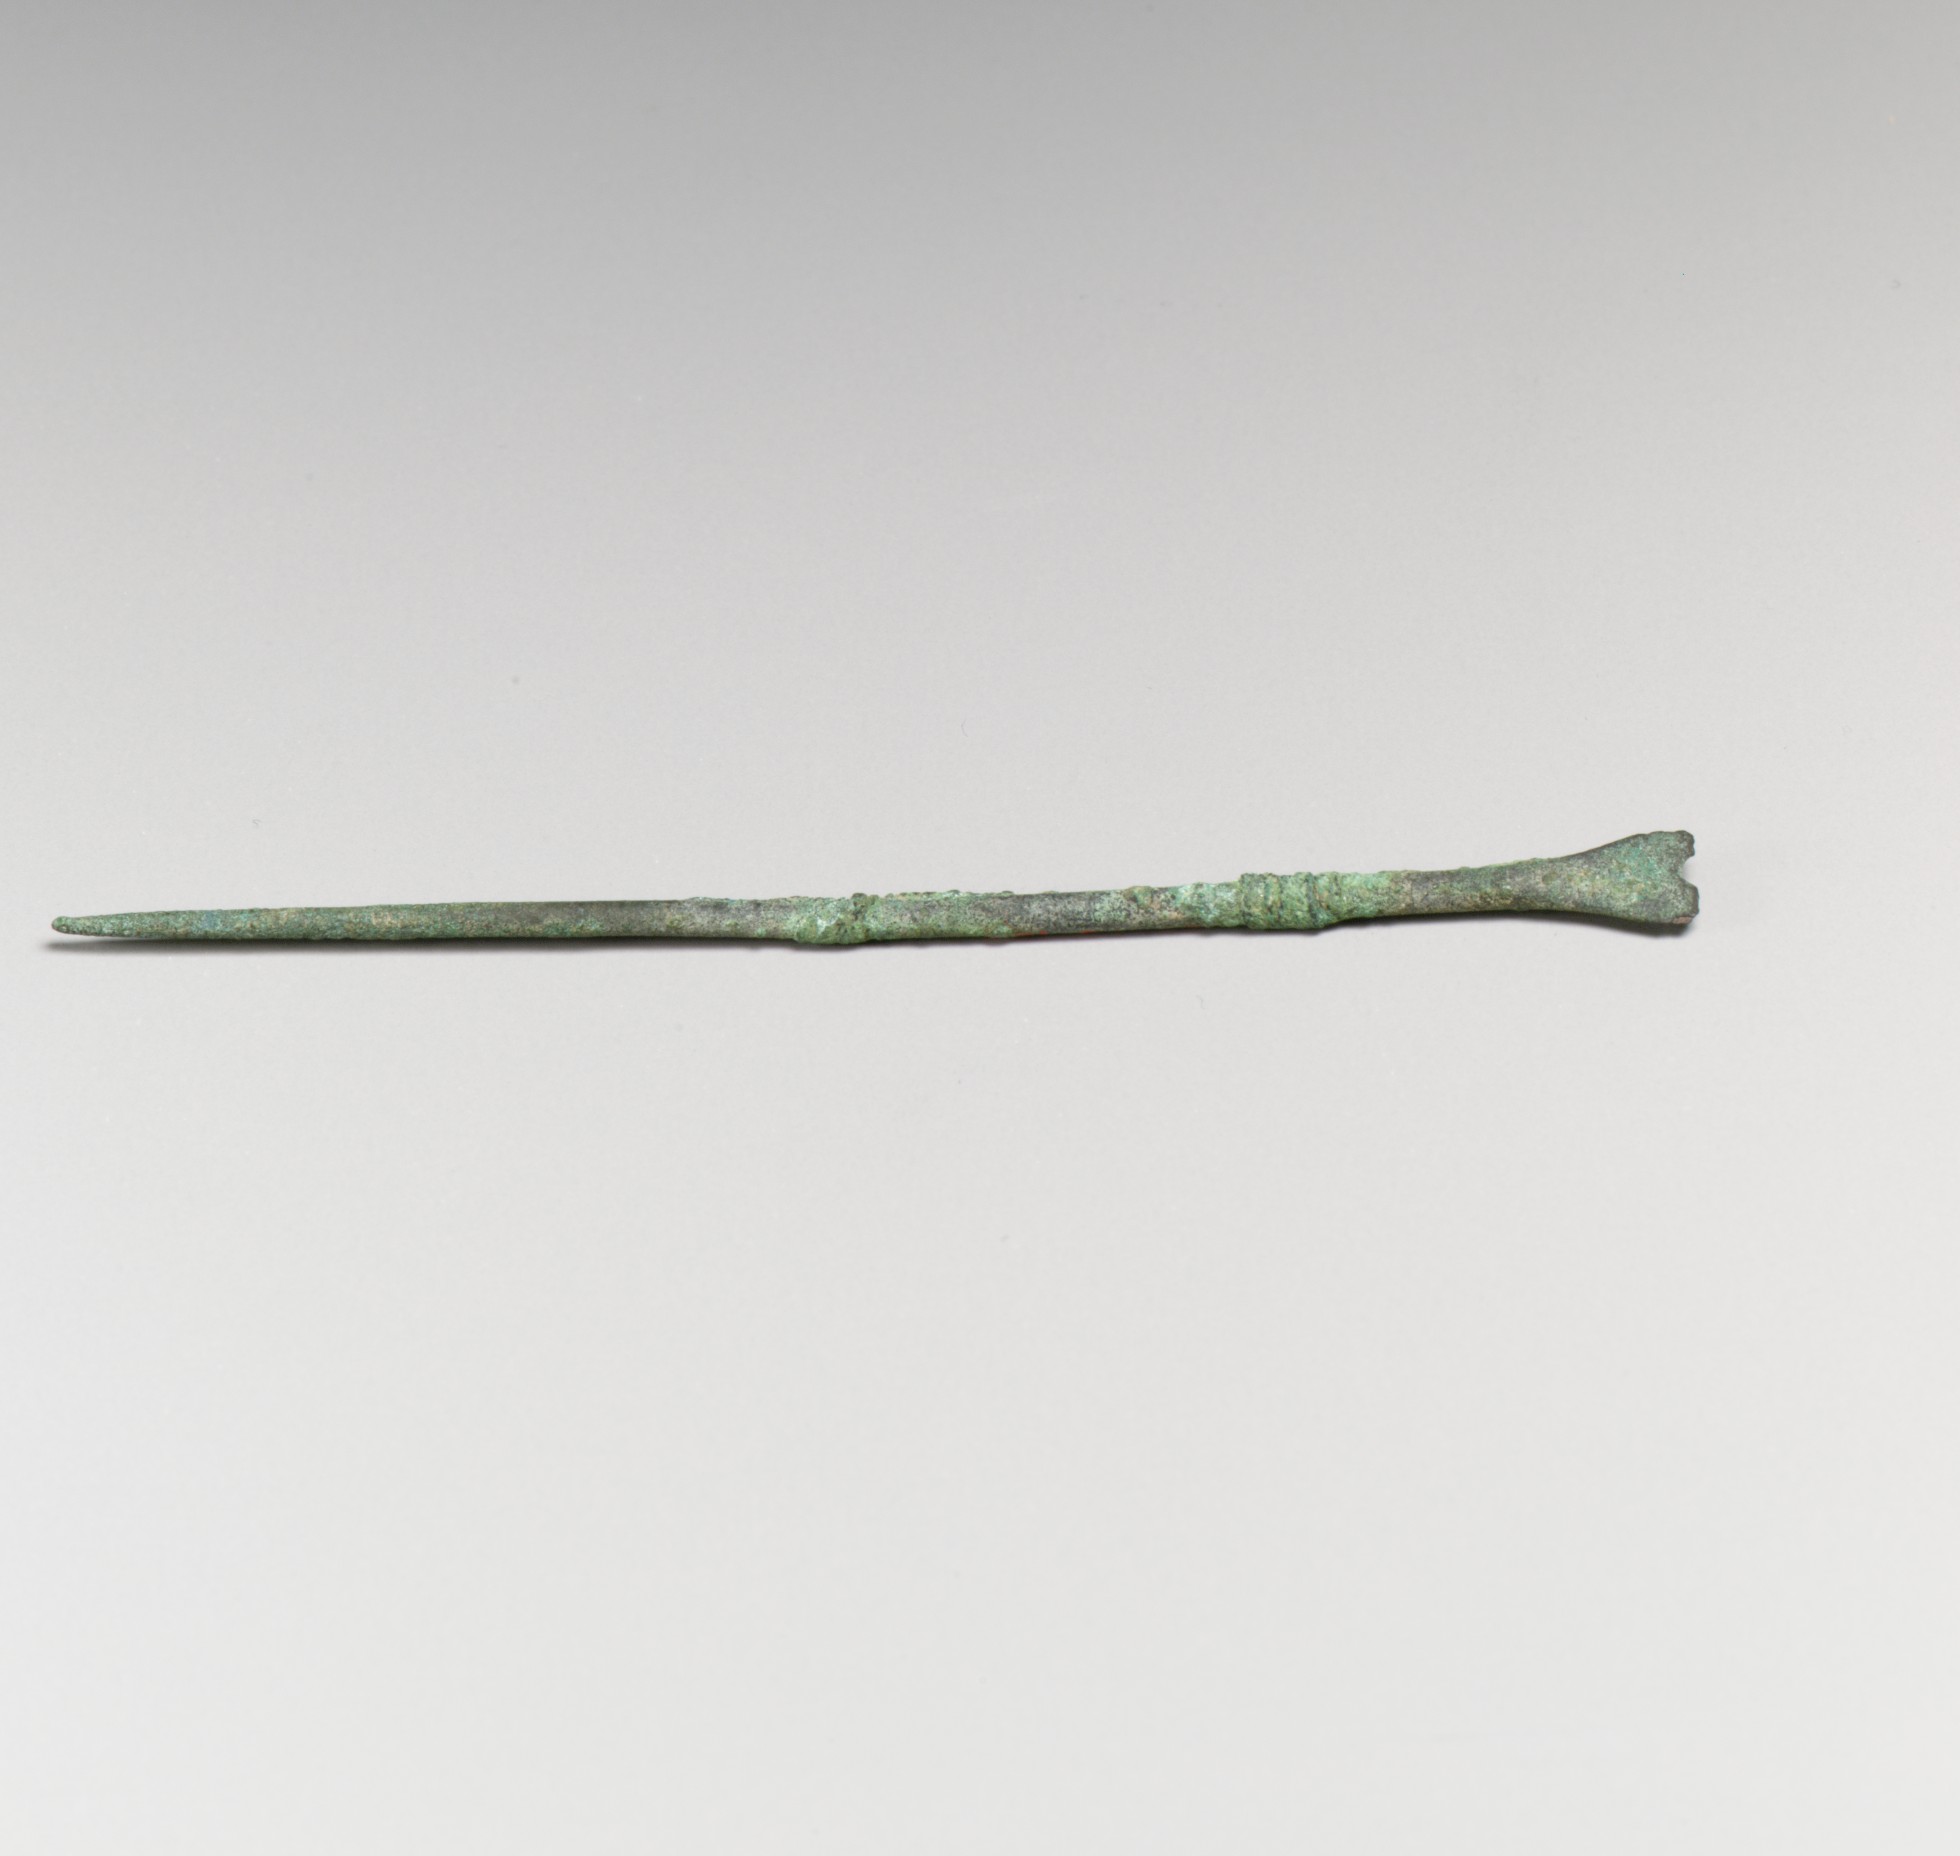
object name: needle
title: Needle ?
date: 7000 BCE-330 CE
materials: bronze